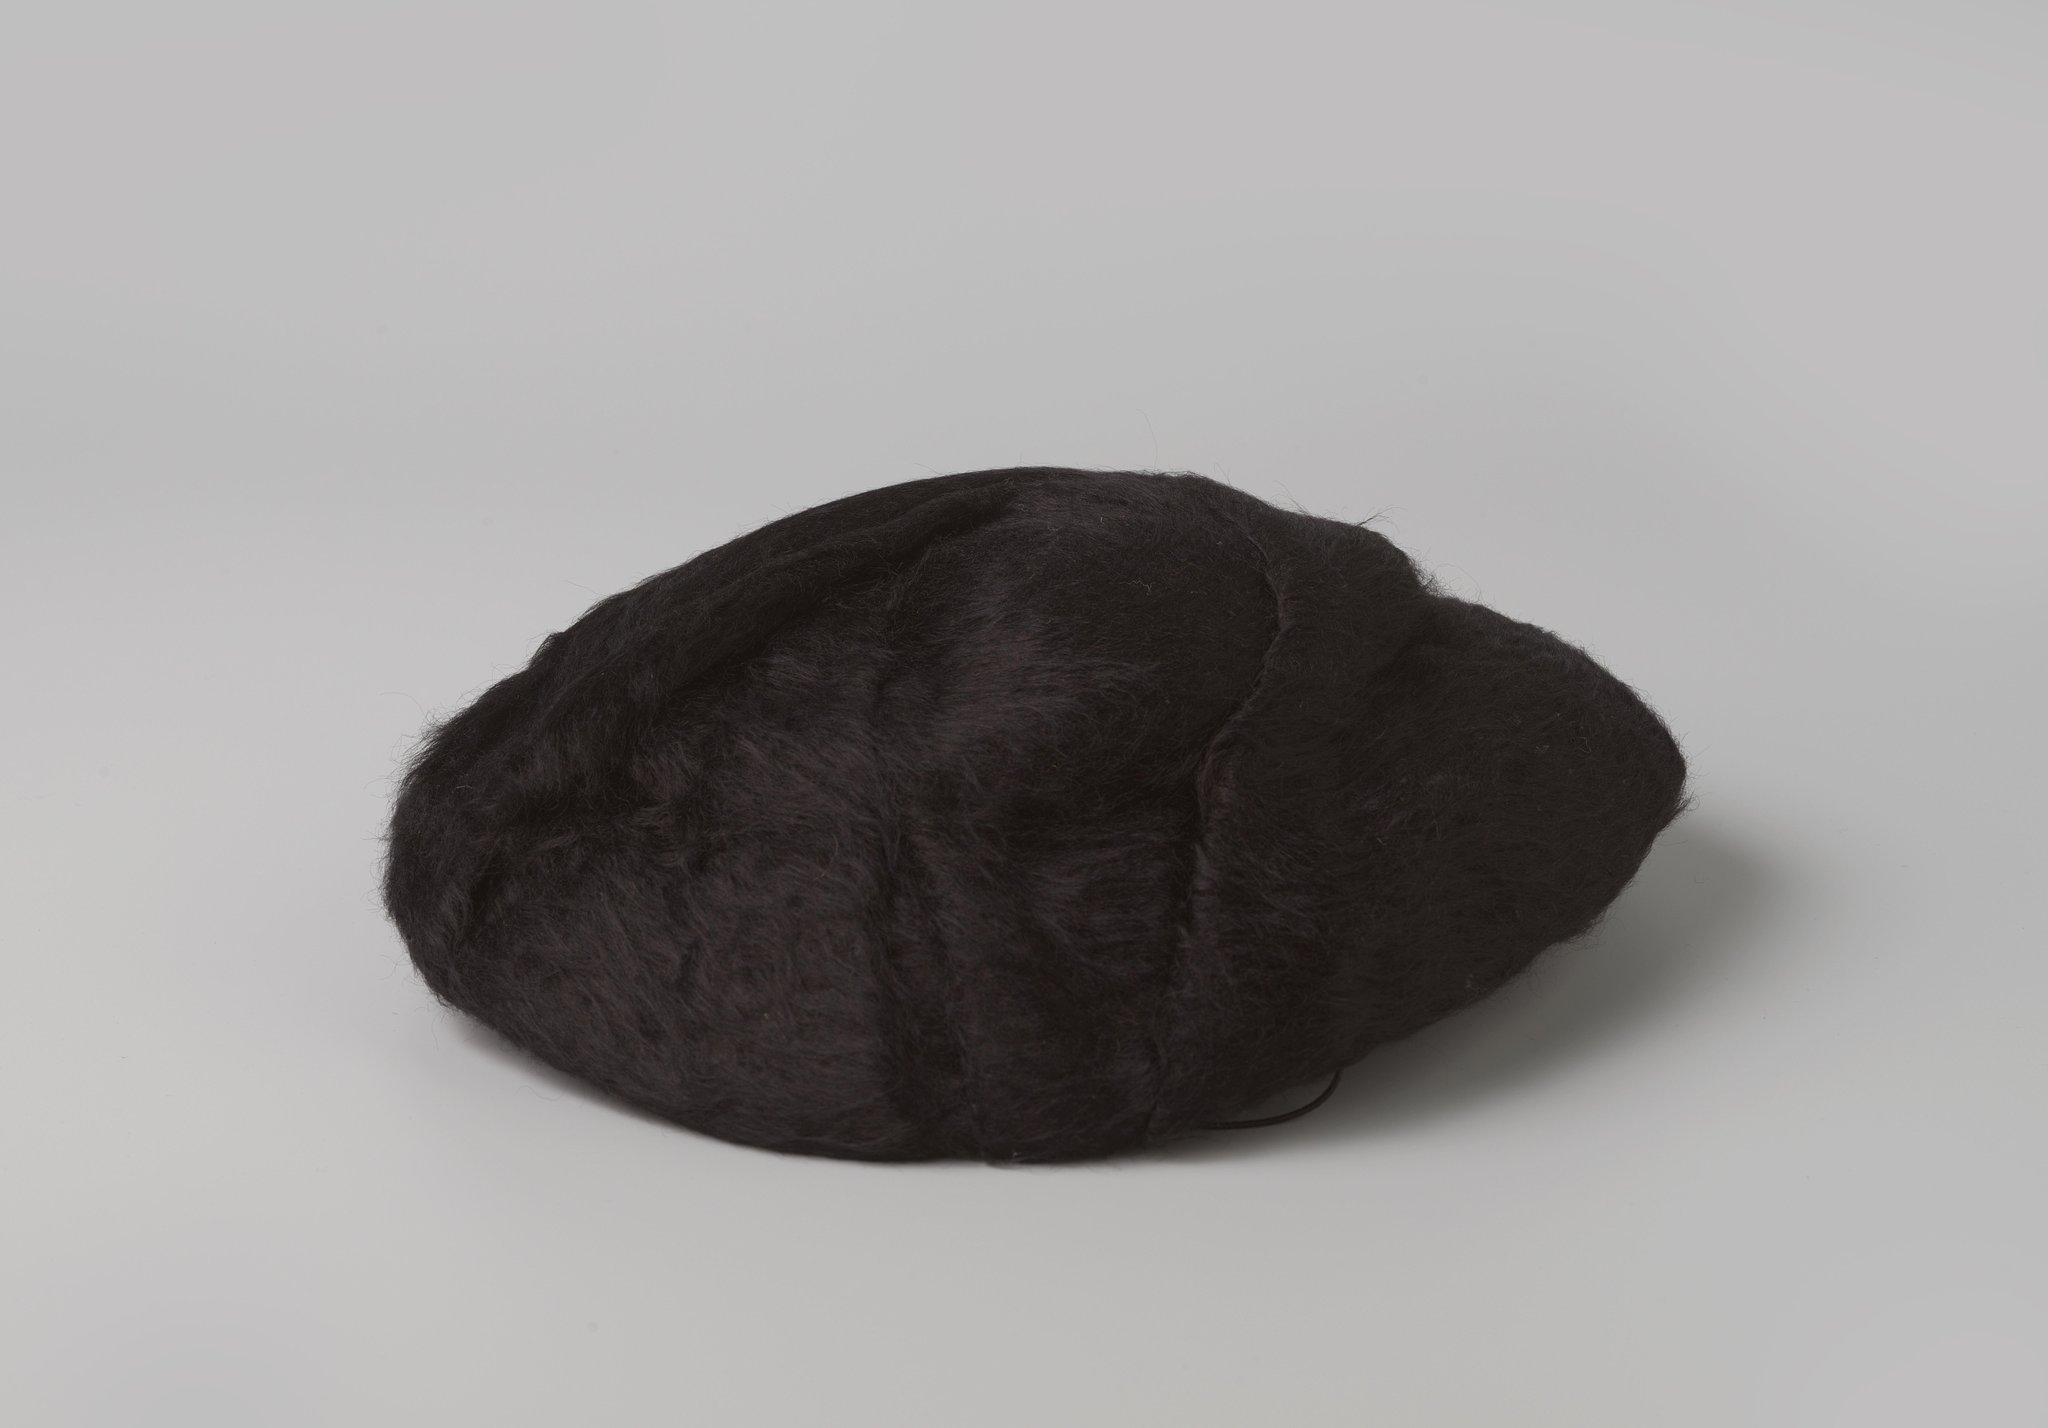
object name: hat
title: Hoed van zwart langharig haarvilt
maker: Anonymous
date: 1947-1950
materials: velvet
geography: netherlands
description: Hoed van zwart langharig haarvilt (?). Pannenkoekmodel van gedrapeerde stof over een met draad verstevigde capeline, met iets neerhangende aangebouwde vlakke rand. Tegenrand met zwart fluweel bekleed.